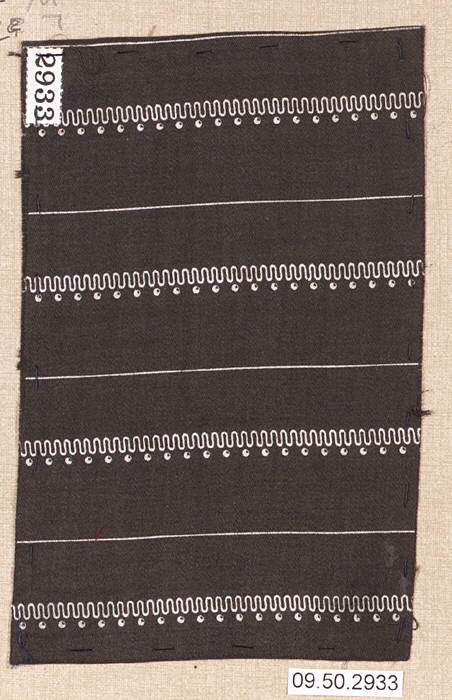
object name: piece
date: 1801-1900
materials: cotton